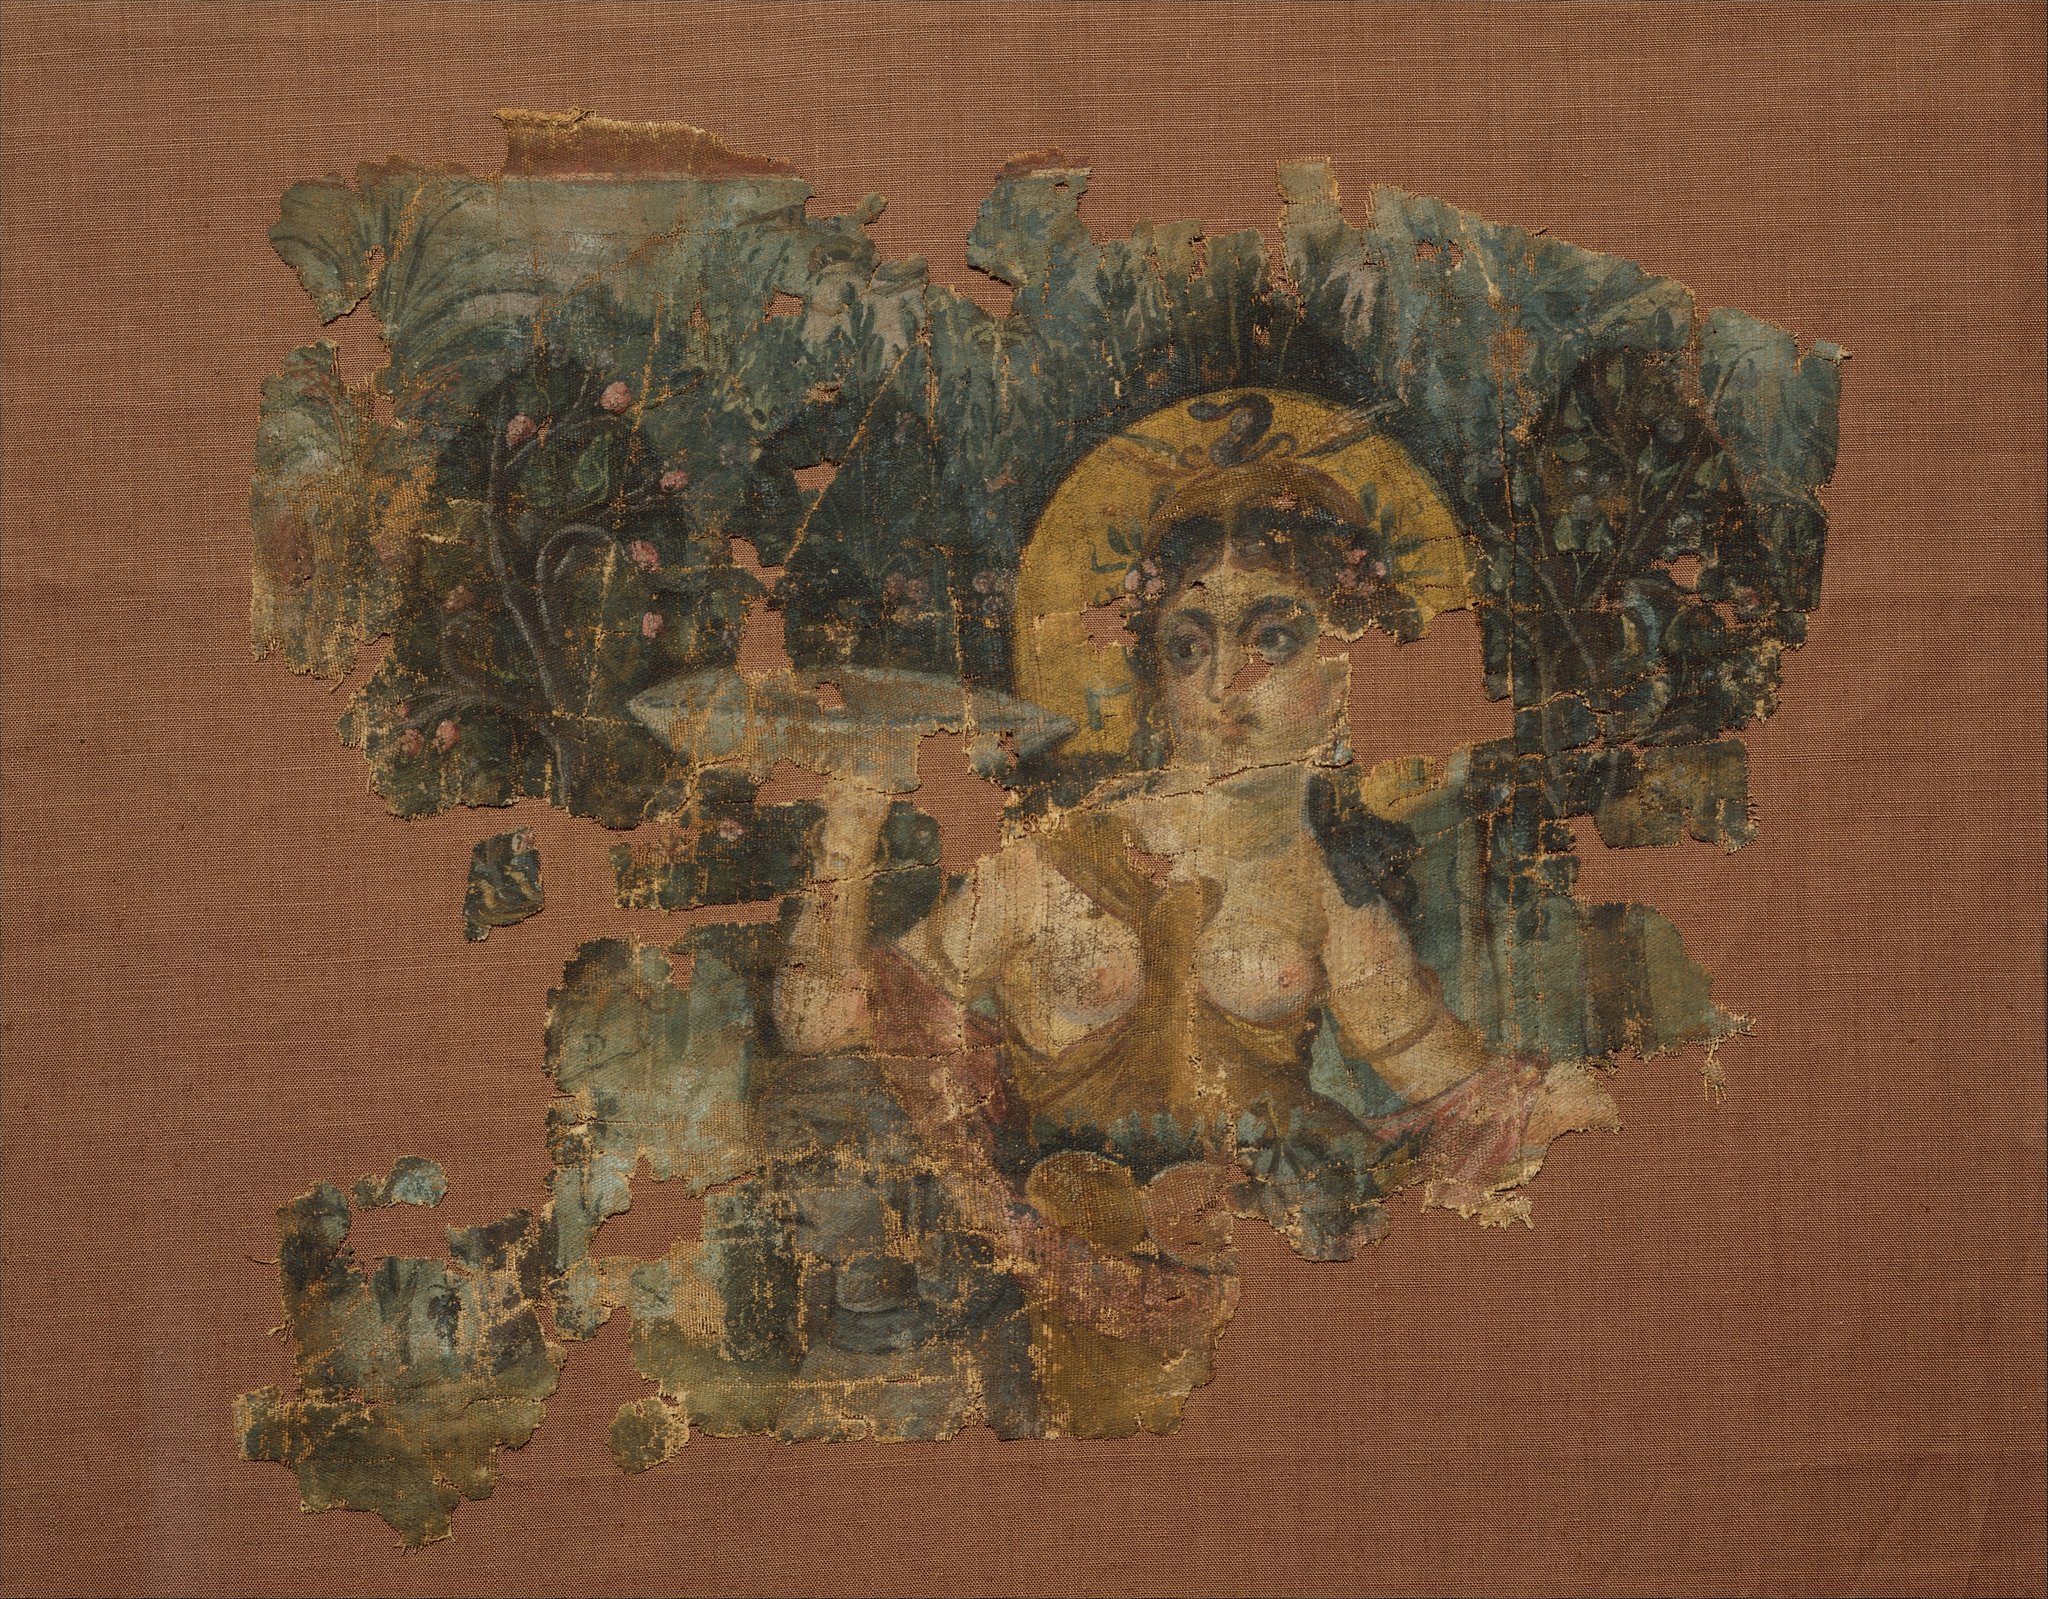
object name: hanging, euthenia in a garden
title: Hanging Showing Euthenia in a Garden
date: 1-100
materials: linen, paint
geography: northern upper egypt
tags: female nudes